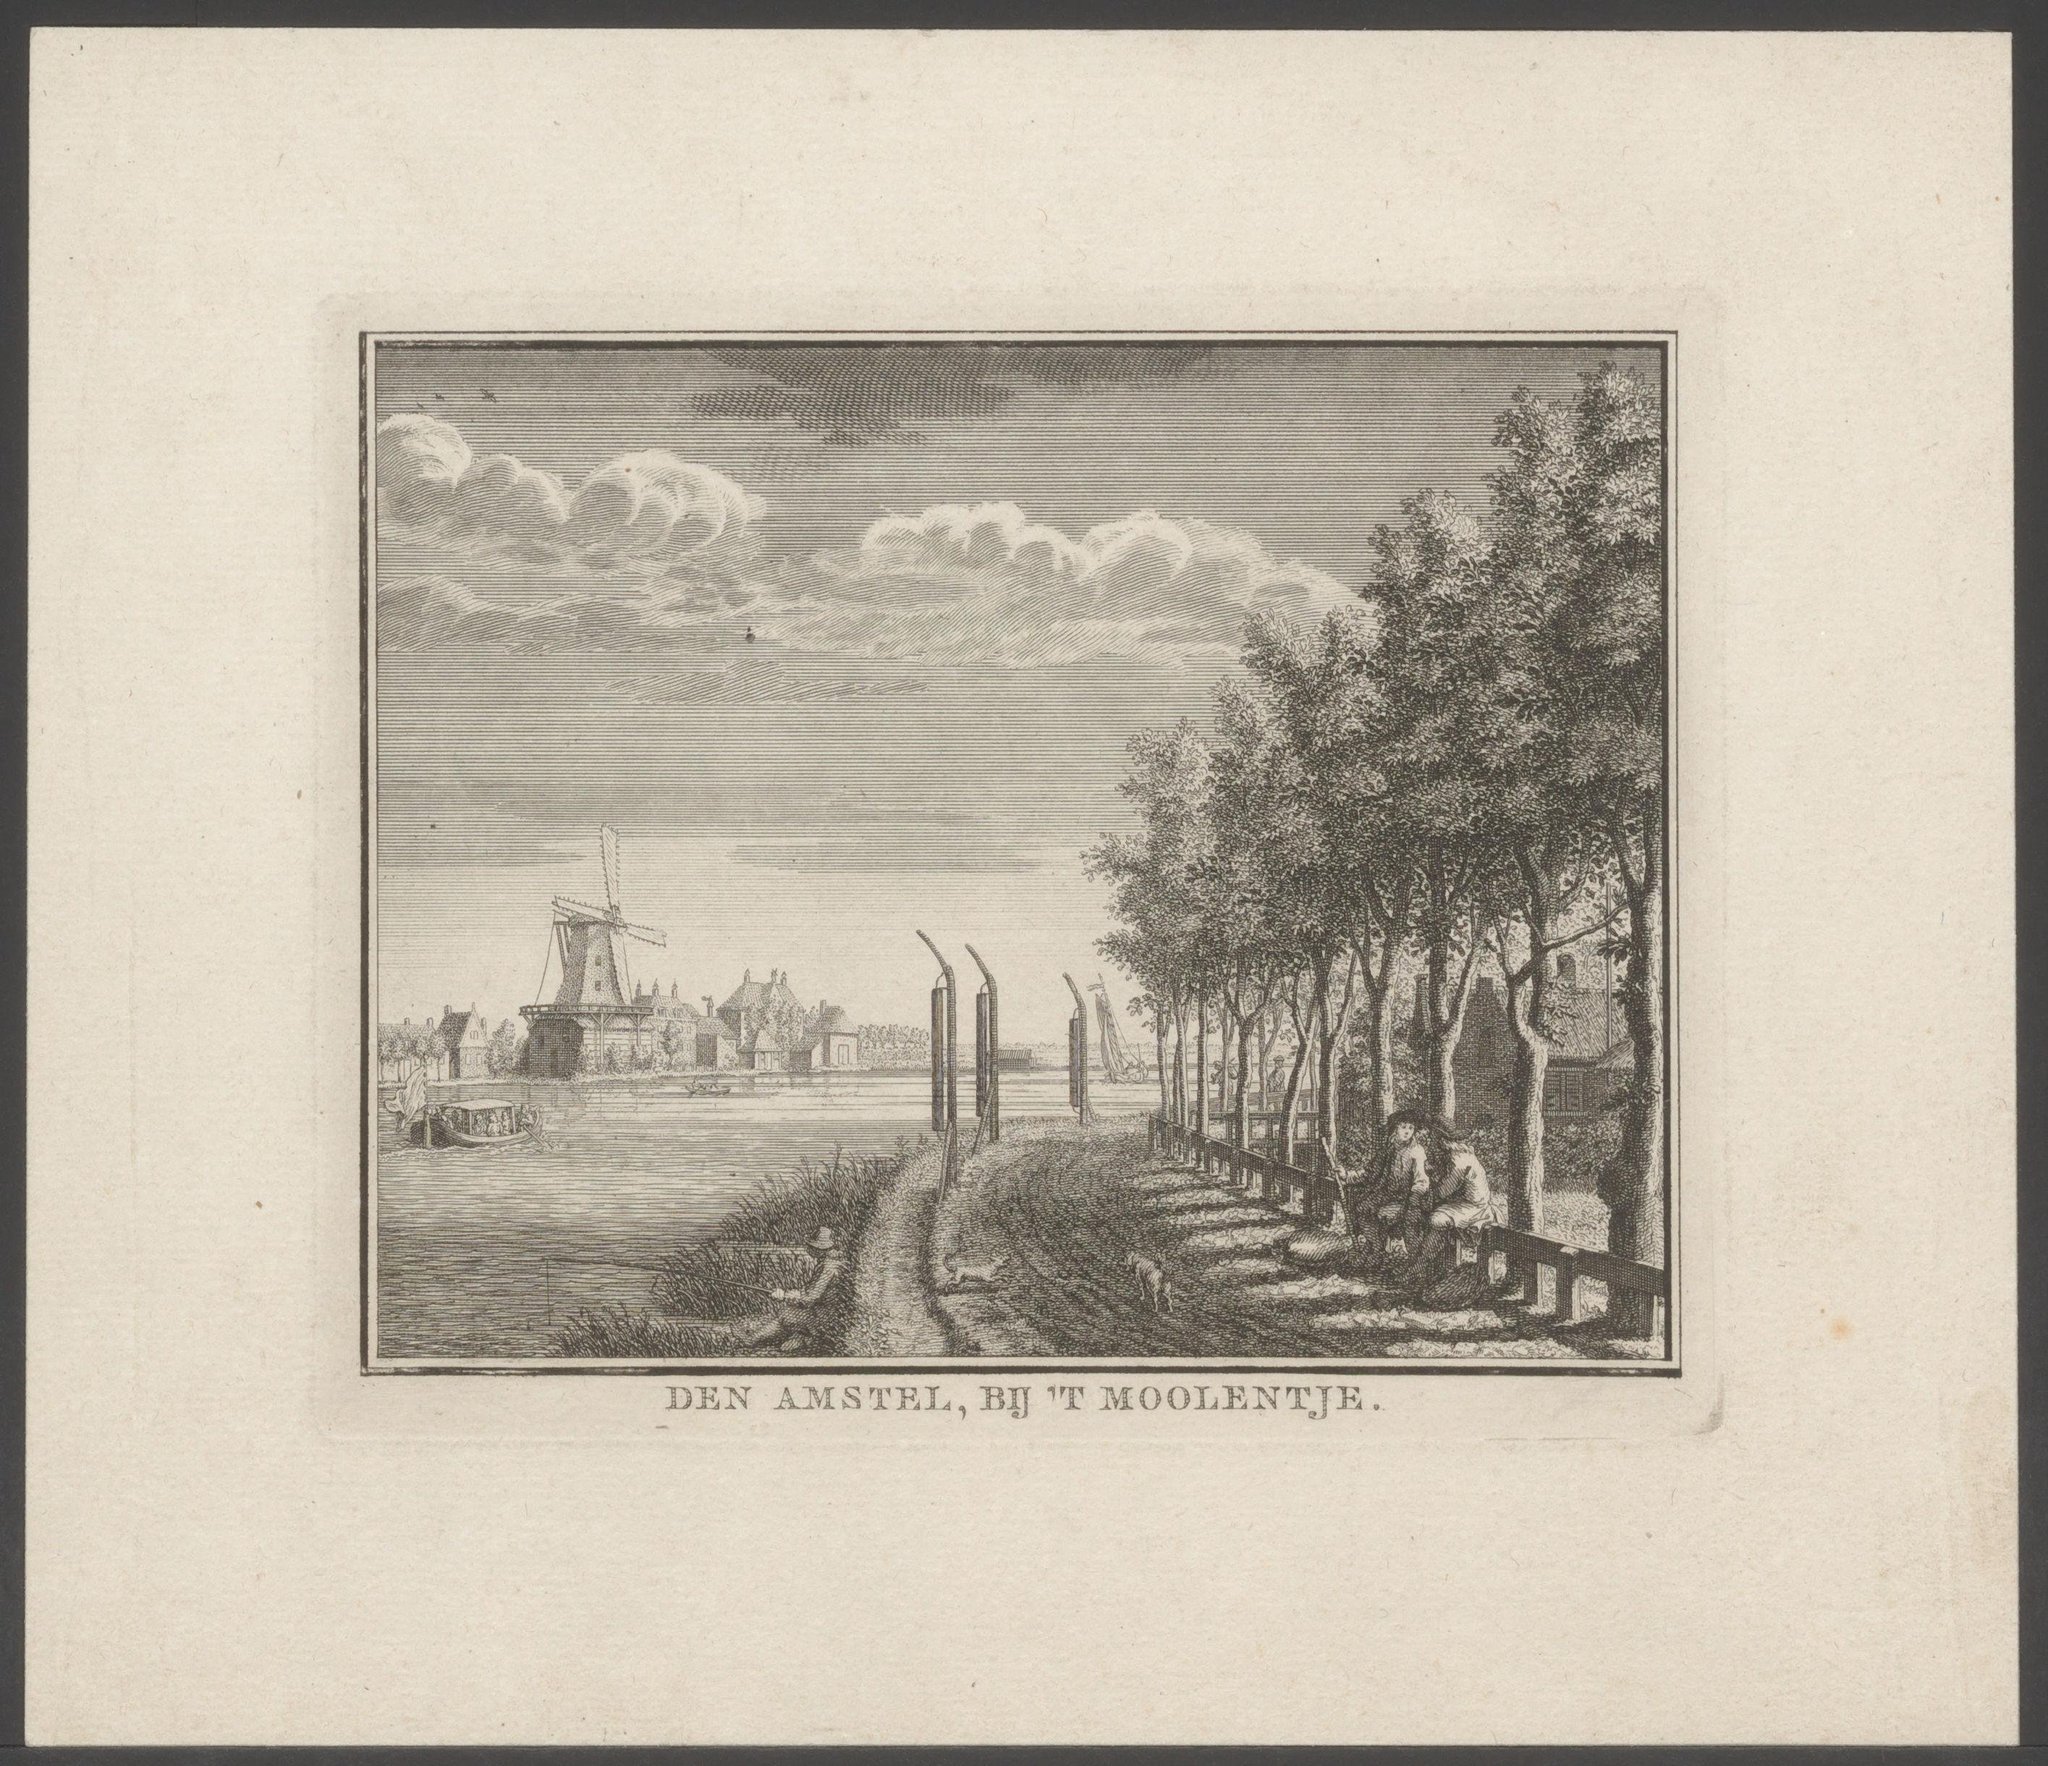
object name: print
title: Den Amstel, bij 't Moolentje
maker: jan caspar philips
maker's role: draughtsman, print maker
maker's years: 1700-1775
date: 1736-1773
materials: paper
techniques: etching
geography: amsterdam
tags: river, inn, coffee-house, public house, etc., village, road, path, windmill in landscape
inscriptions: collector's mark: ‘5’ Lugt 1641b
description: Andere staat van prent gebruikt in: Schoemaker, Gerrit ed. Daniel Willinks Amstellandsche Arkadia, of beschryving van de gelegenheit, toestant en gebeurtenissen van Amstellandt, met deszelfs onderhoorige dorpen, heerlykheden, ambachten, lusthoven, wateren, enz. (…). 2 delen. 1e druk. Amsterdam: Arend van Huyssteen, 1737, dl. 1, p. 88. En in: Schoemaker, Gerrit ed. Daniel Willinks Amstellandsche Arkadia, of beschryving van de gelegenheit, toestant en gebeurtenissen van Amstellandt, met deszelfs onderhoorige dorpen, heerlykheden, ambachten, lusthoven, wateren, enz. (…). 2 delen. 2e druk. Utrecht: Samuel de Waal, 1773, dl. 1, p. 85.